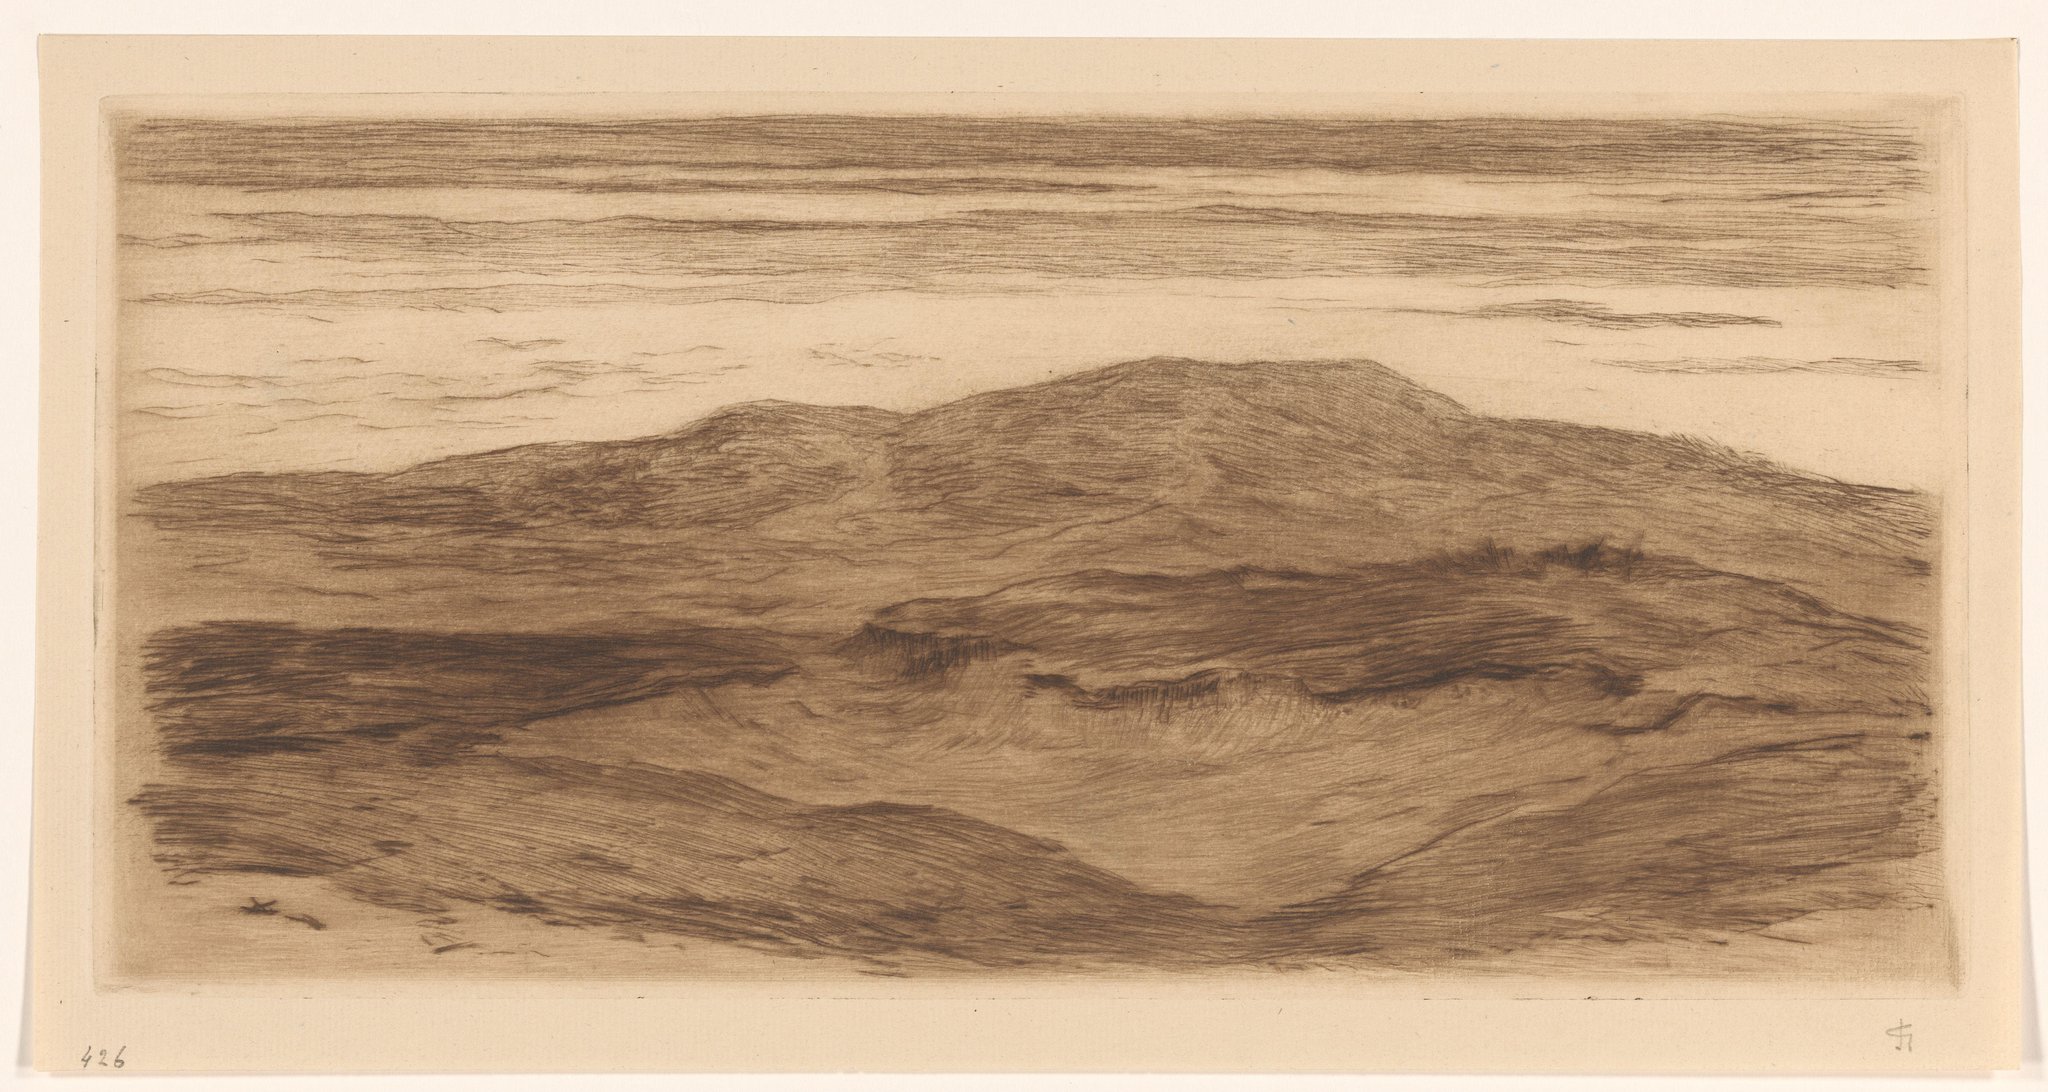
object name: print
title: Duinlandschap bij Scheveningen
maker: carel nicolaas storm van s-gravesande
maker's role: draughtsman, print maker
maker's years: 1841-1924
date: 1851-1902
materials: paper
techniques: drypoint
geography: netherlands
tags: dune coast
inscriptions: collector's mark: Lugt 2228, number: ‘426’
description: Mogelijk vermeld in: Storm van 's-Gravesande, Charles. Catalogue des eaux-fortes et lithographies. New York: s.n., 1903, of in een onbekende latere uitgave van het manuscript. Vermoedelijk vermeld als catalogusnummer 426.